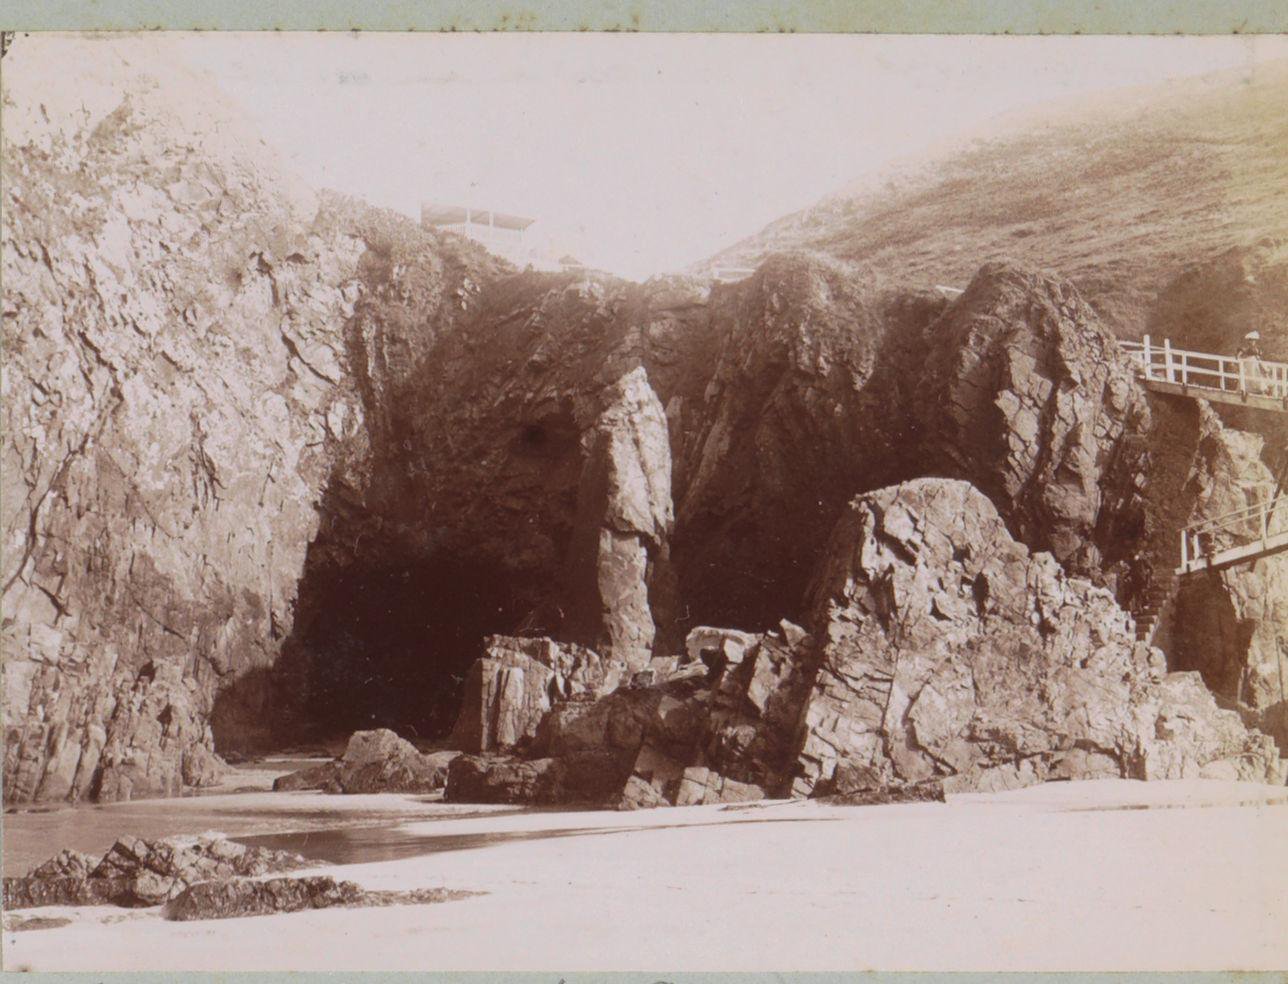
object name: photograph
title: Gezicht op de grot van Plemont op Jersey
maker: delizy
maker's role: manufacturer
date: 1896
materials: paper, photographic support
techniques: gelatin silver print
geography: jersey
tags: cave, grotto, rocks (+ landscape with figures, staffage), coast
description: Onderdeel van Fotoalbum van een Franse amateurfotograaf met opnames van uitstapjes in Frankrijk, Spanje, België, Luxemburg en Nederland, de eerste automobielen en autoraces.